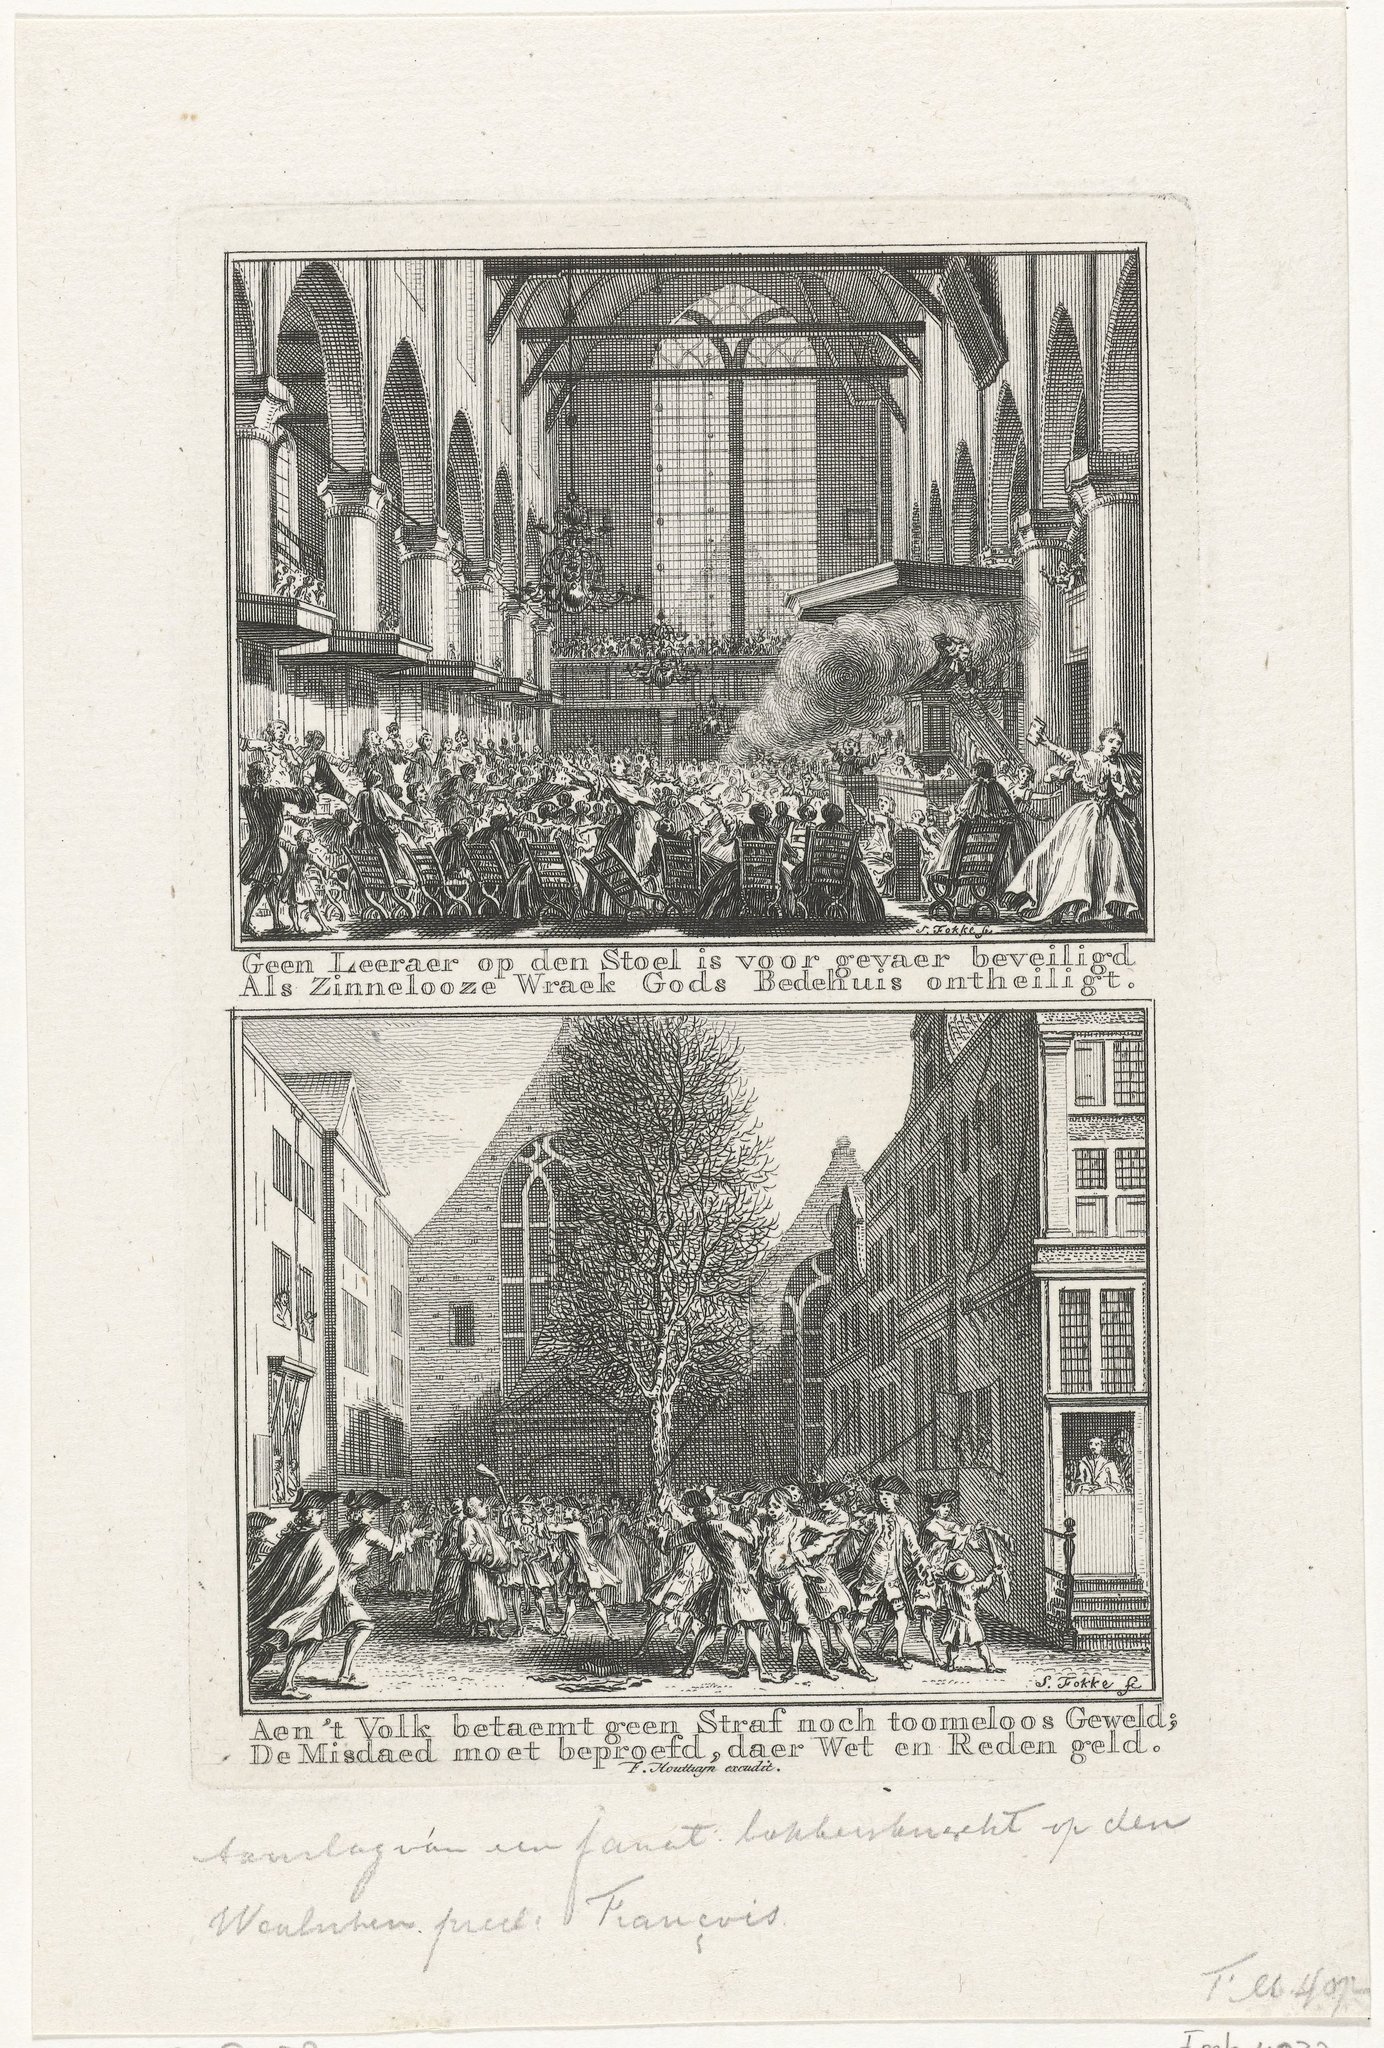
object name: print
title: Oproer op het Walenplein te Amsterdam, 1755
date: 1755-1757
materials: paper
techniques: etching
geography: amsterdam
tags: church (exterior), interior of church, murder, street-fights, riots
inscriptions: collector's mark: Lugt 2228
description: Aanslag in de Waalse Kerk van een fanatieke bakkersknecht op de predikant François tijdens de dienst en het oproer op het Walenplein te Amsterdam.Twee voorstellingen op een plaat. Onder elke voorstelling een tweeregelig onderschrift.